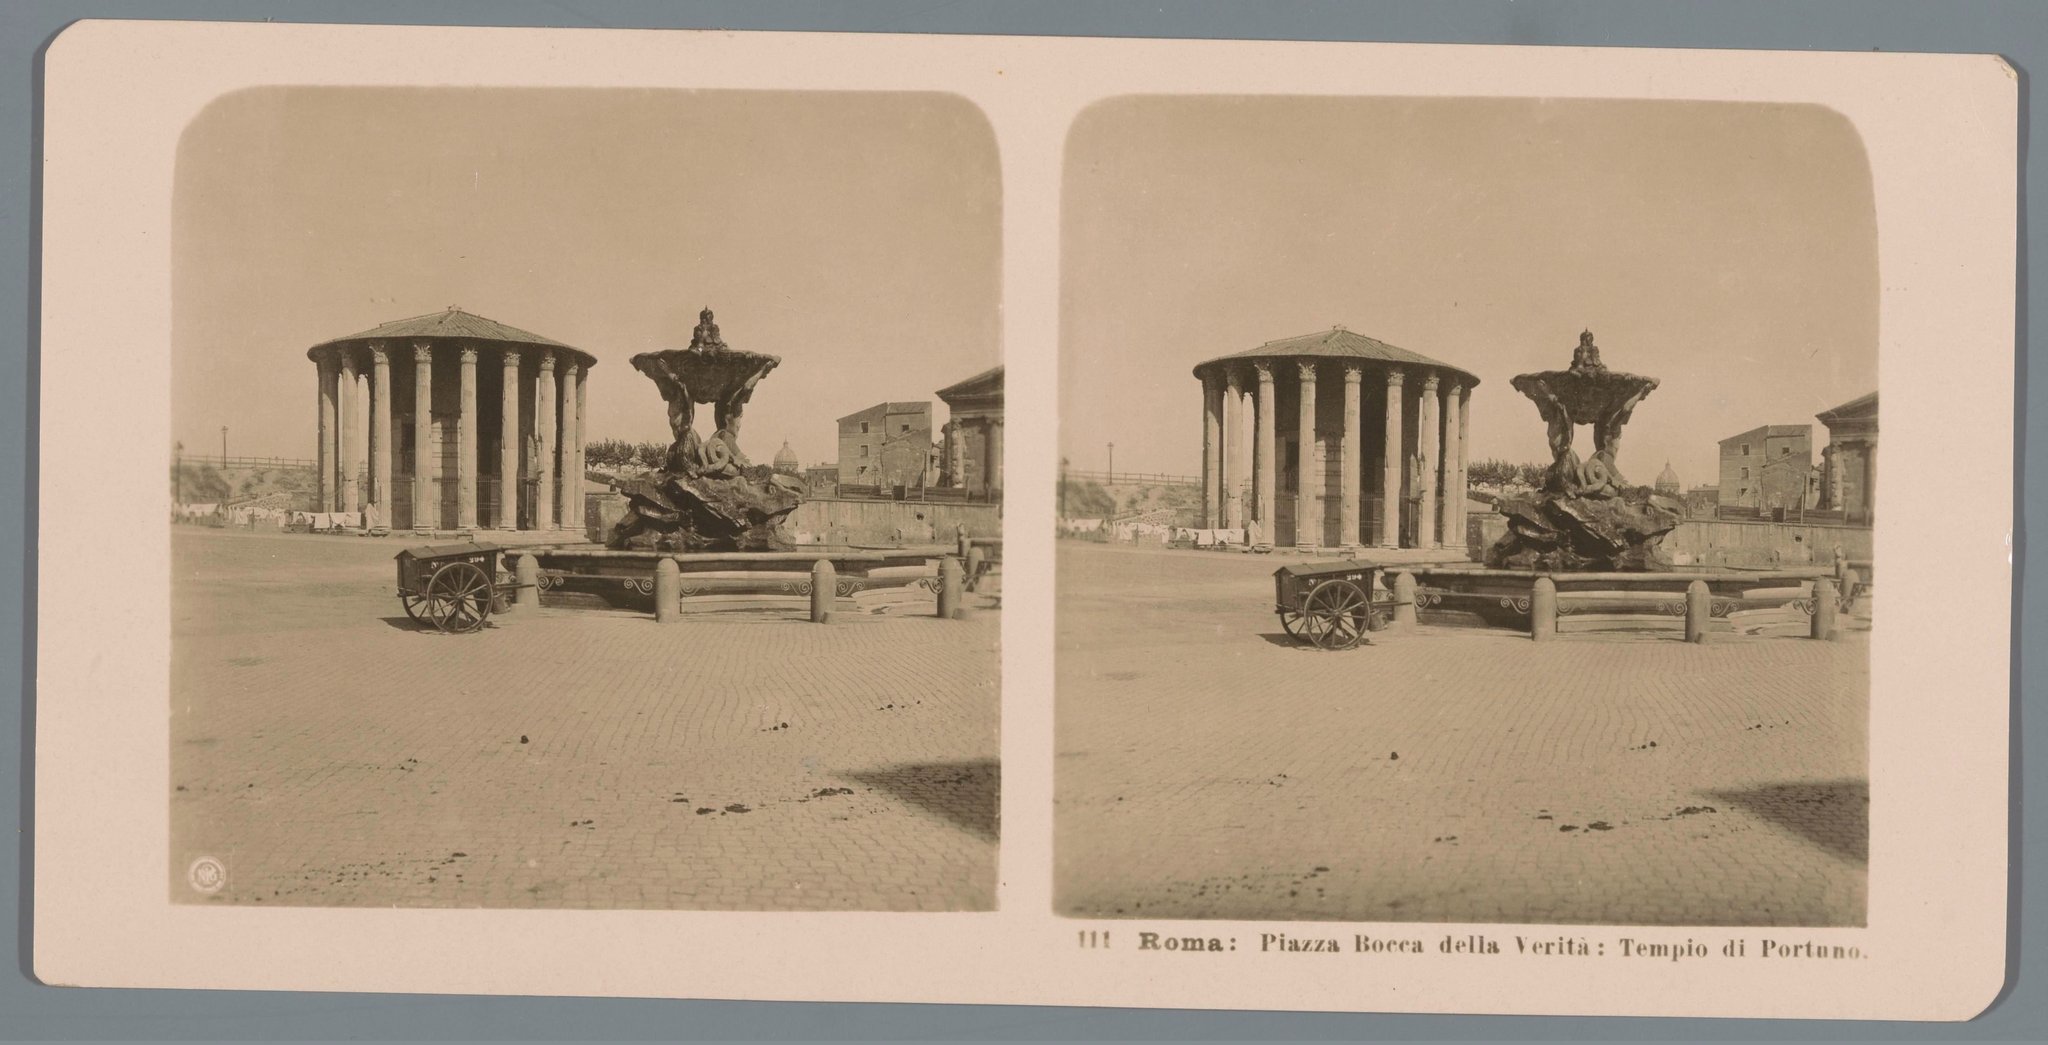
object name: stereograph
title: Roma: Piazza Bocca della Verità: tempio di Portuno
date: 1900-1910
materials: cardboard, photographic support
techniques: gelatin silver print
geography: forum boarium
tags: temple, shrine ~ roman religion, village square, place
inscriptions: inscription: ‘NPG’, number: ‘111’